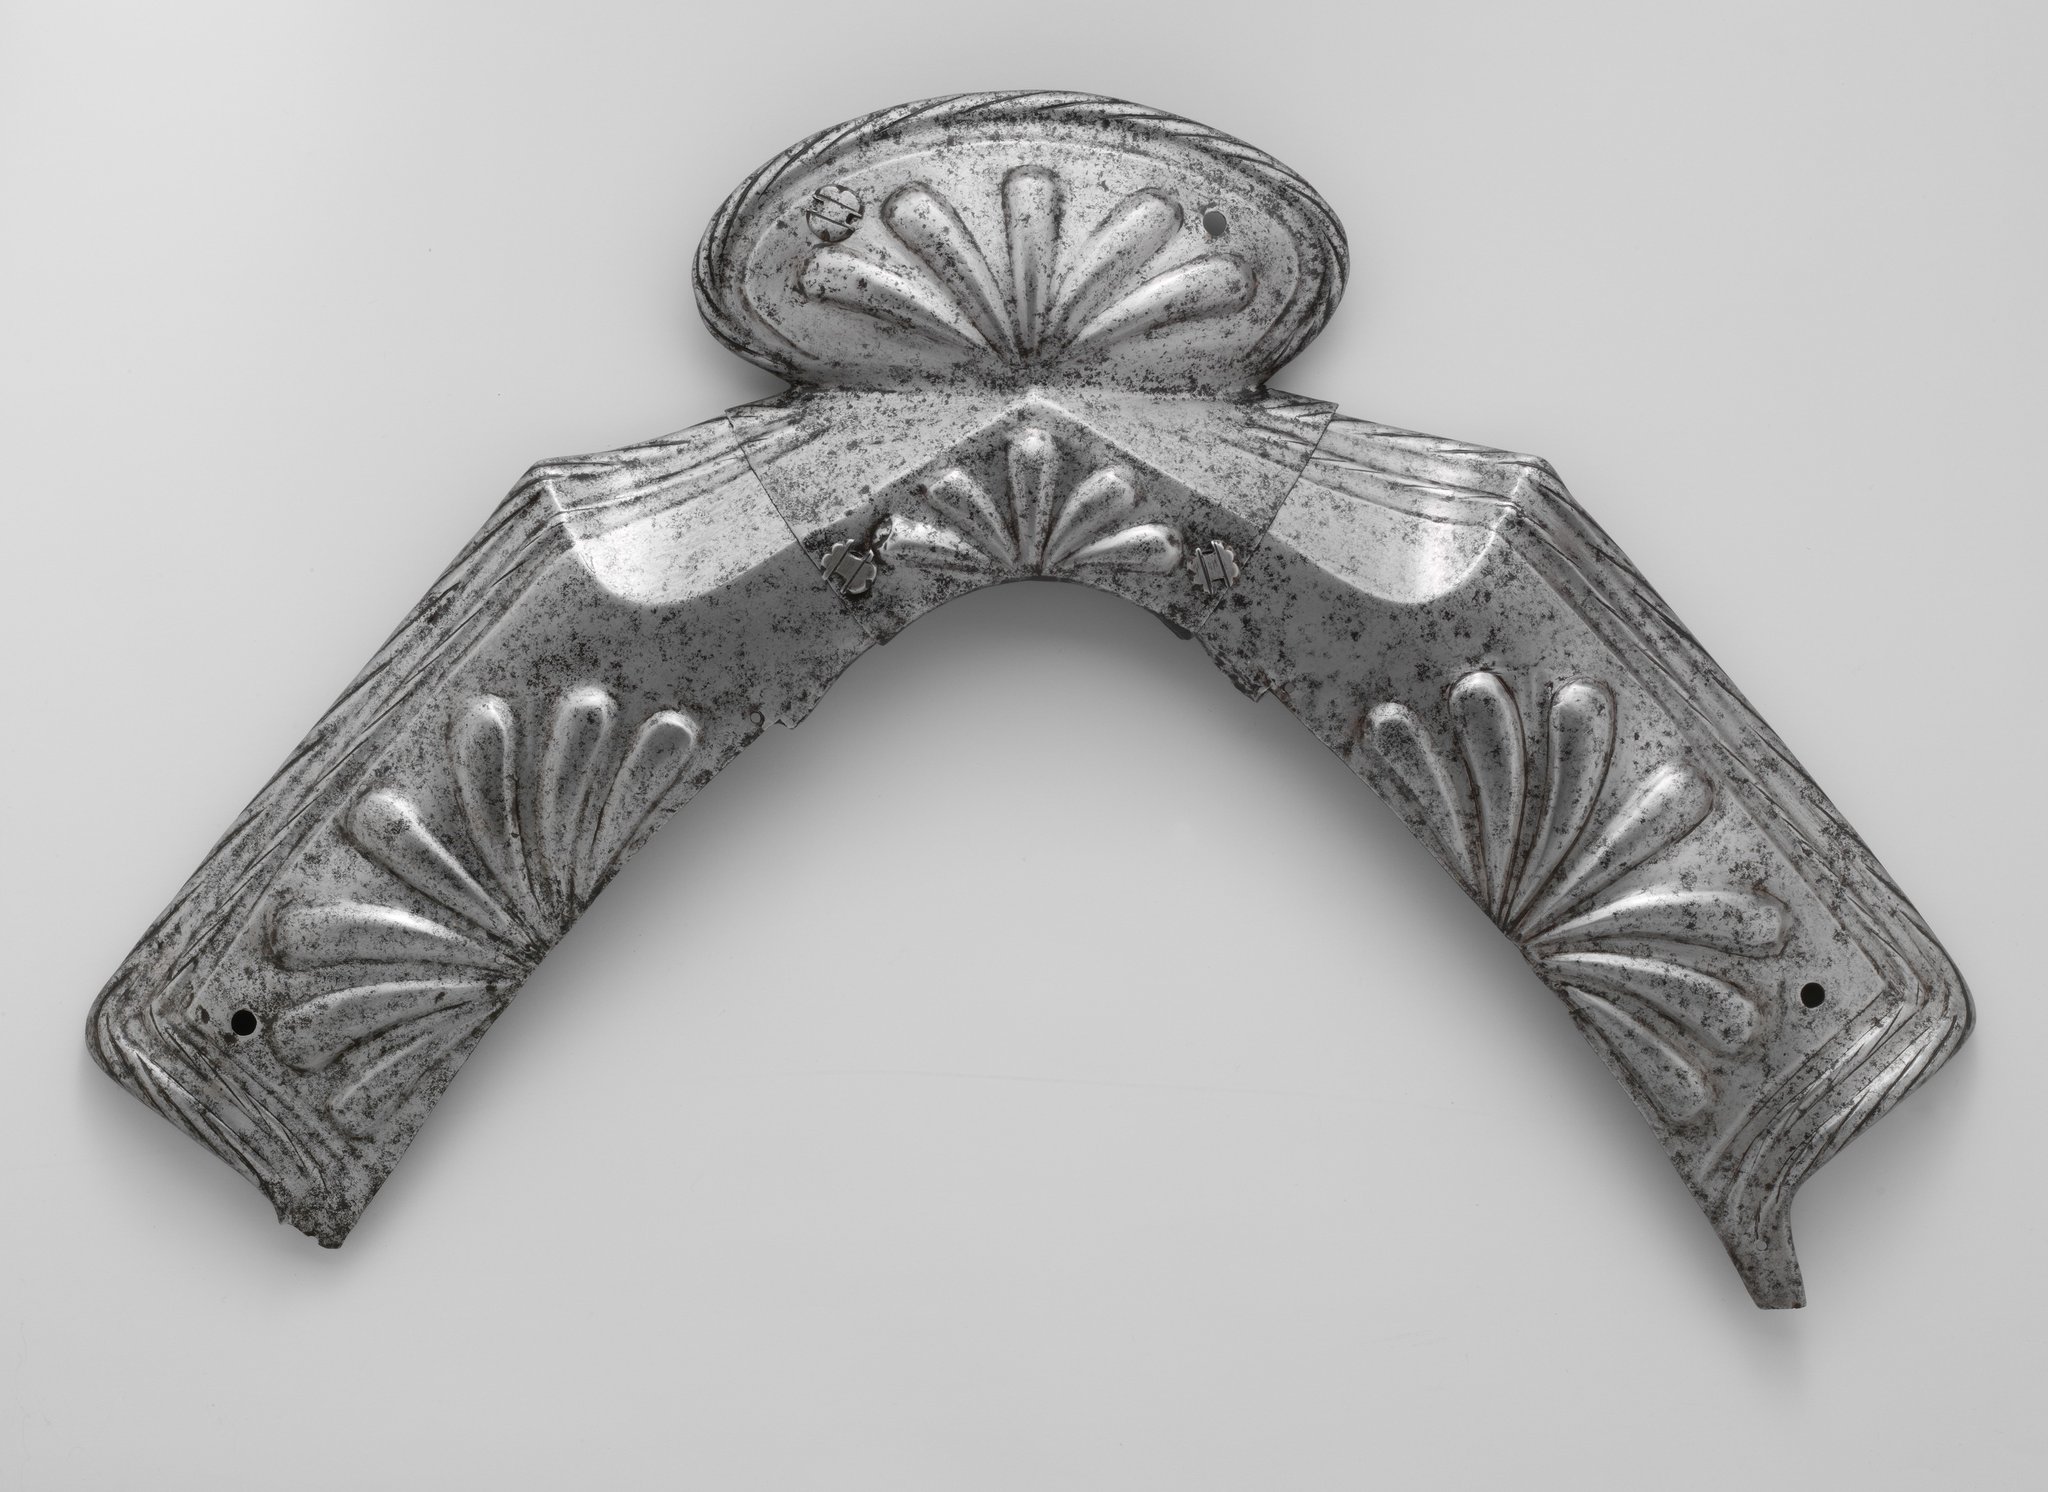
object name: pommel plate from a saddle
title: Three Pommel Plates of a Saddle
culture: german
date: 1520-1540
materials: steel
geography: germany